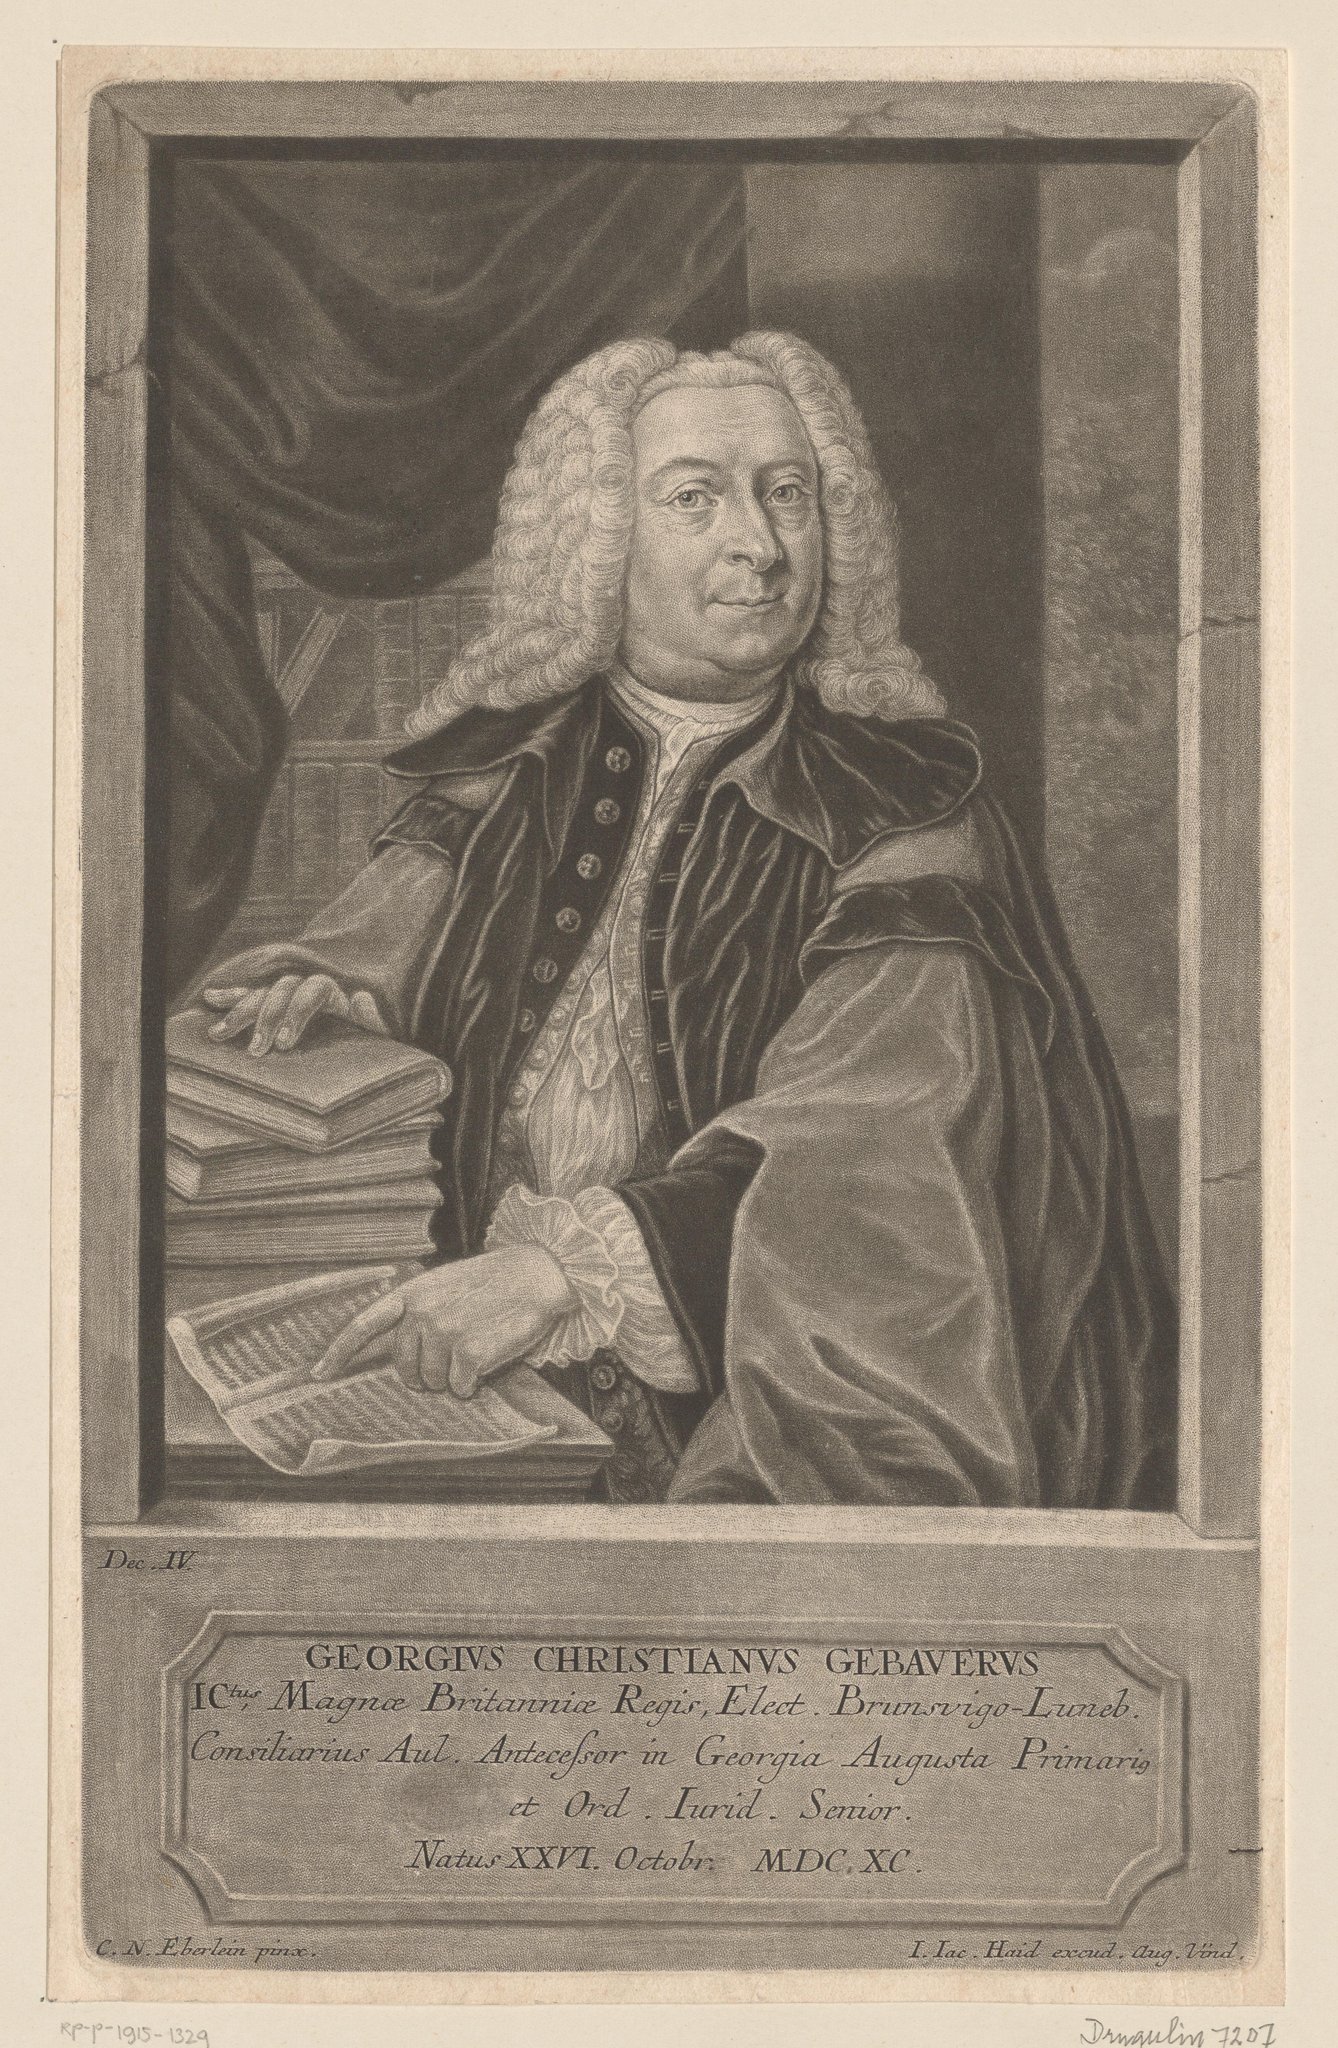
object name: print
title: Portret van Georg Christian Gebauer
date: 1745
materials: paper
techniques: mezzotint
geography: augsburg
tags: historical persons, professor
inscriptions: collector's mark: Lugt 2228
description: Prent ook gebruikt voor: Brucker, Jacob. Bildersal heutiges Tages lebender und durch Gelahrheit berühmter Schrifftsteller. Augsburg: Johann Jacob Haid, 1745.